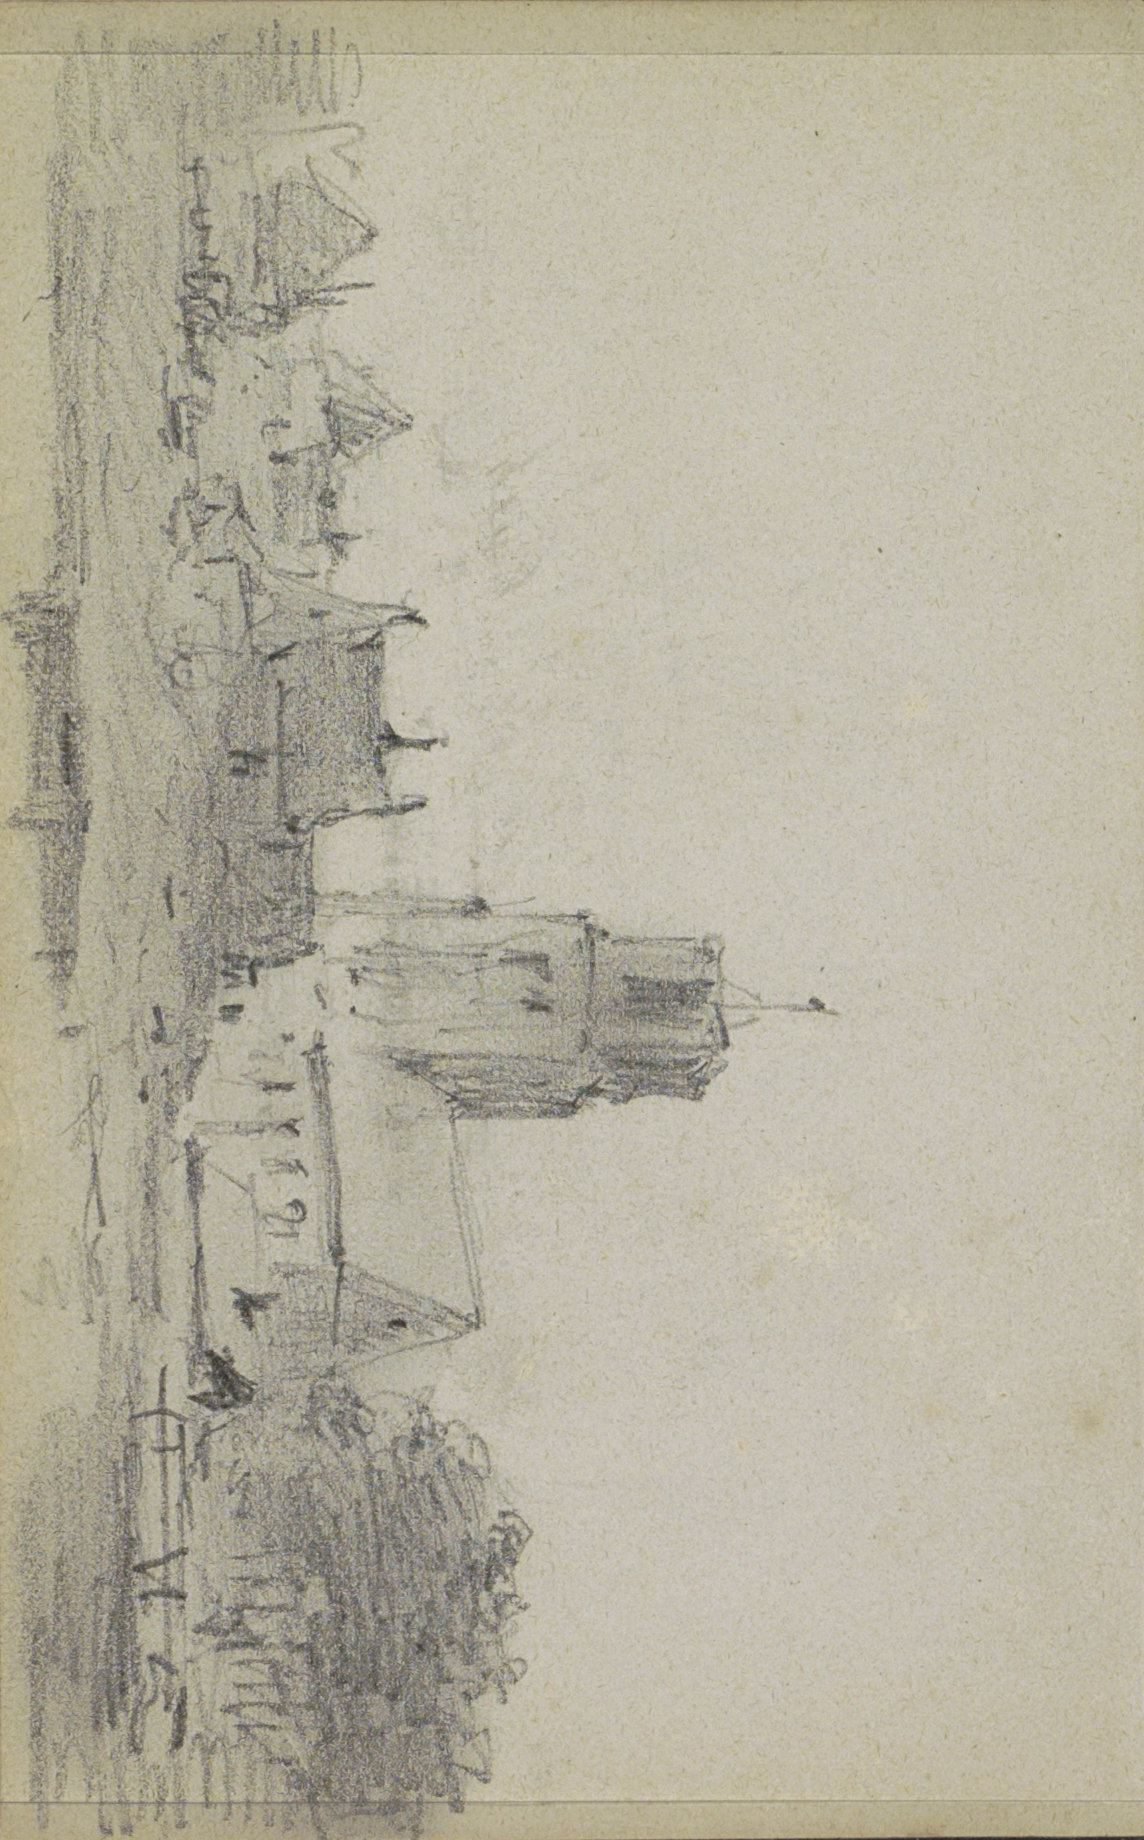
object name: sketchbook leaf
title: Stadsgezicht met een kerk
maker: adrianus eversen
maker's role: draughtsman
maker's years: 1818-1897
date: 1828-1897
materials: paper, pencil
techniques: stumping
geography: netherlands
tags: city-view, and landscape with man-made constructions, church (exterior)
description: Stadsgezicht met een kerk. Blad 7 verso uit een schetsboek met 58 bladen.